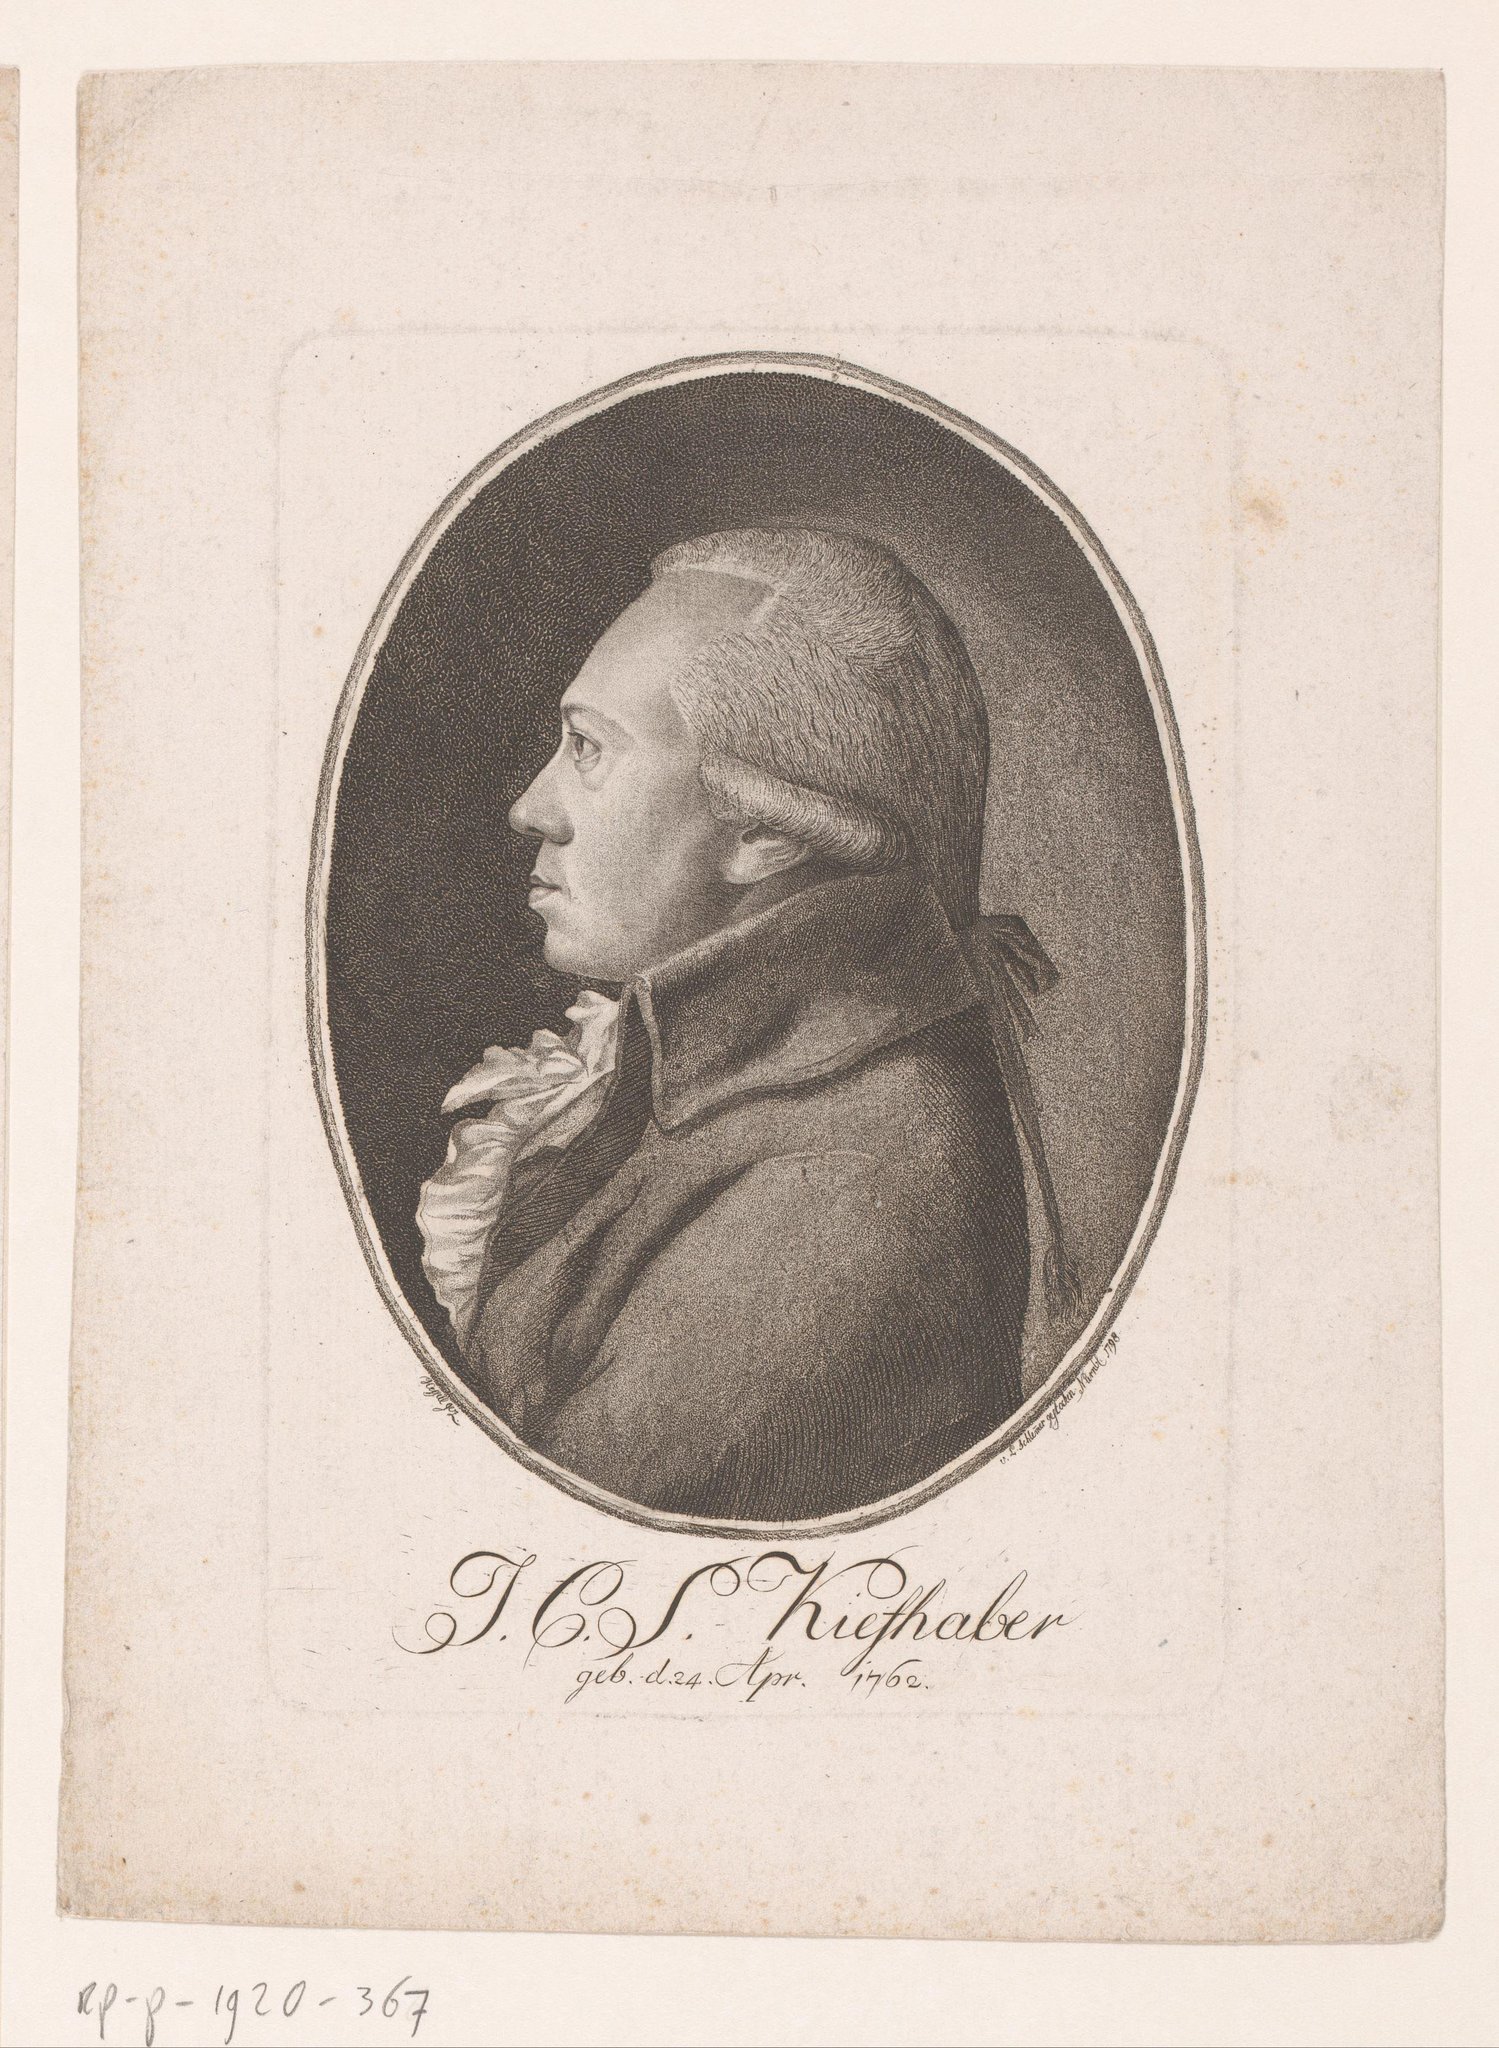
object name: print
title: Portret van Johann Carl Sigmund Kiefhaber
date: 1782-1818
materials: paper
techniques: etching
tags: historical persons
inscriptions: collector's mark: Lugt 2228